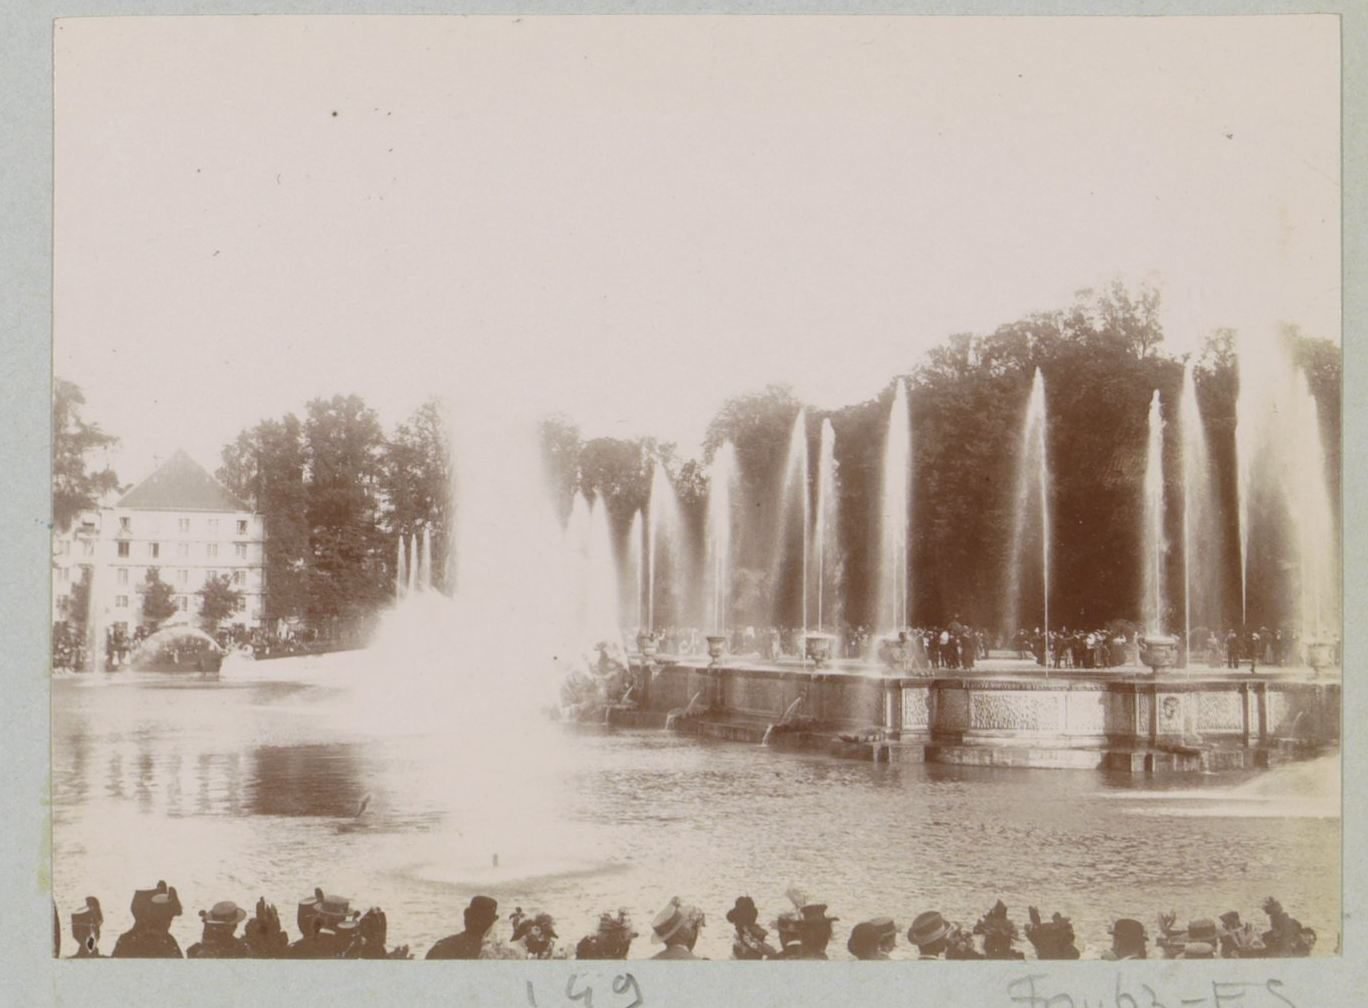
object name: photograph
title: Publiek bij fonteinen in Versailles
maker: delizy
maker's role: manufacturer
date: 1897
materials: paper, photographic support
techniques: gelatin silver print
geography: versailles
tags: garden fountain, public gardens, park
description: Onderdeel van Fotoalbum van een Franse amateurfotograaf met opnames van uitstapjes in Frankrijk, Spanje, België, Luxemburg en Nederland, de eerste automobielen en autoraces.